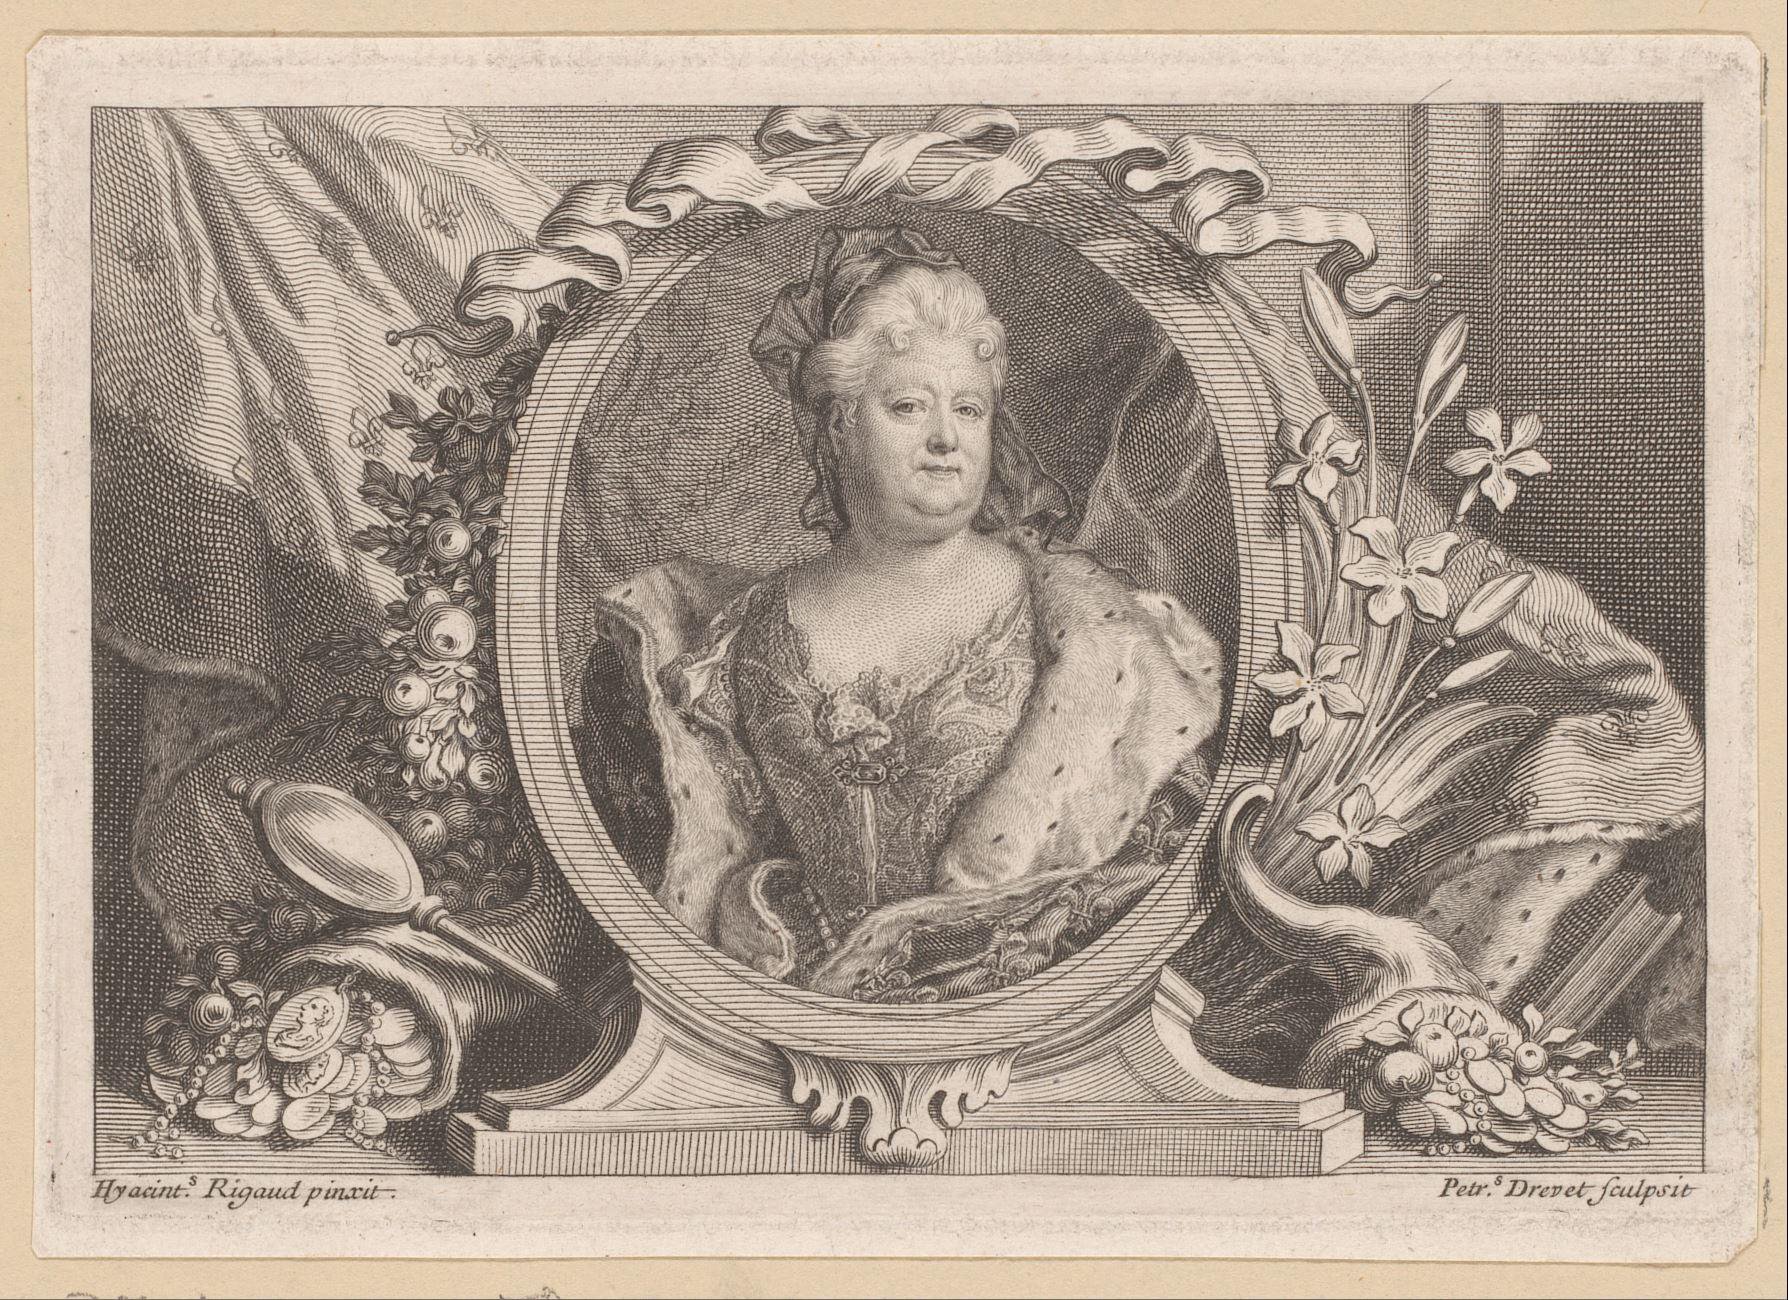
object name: print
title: Portret van Elisabeth Charlotte van Orléans in ovalen lijst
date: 1723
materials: paper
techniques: engraving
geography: france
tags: historical persons - bb - woman, ornament ~ medallion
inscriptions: collector's mark: Lugt 240